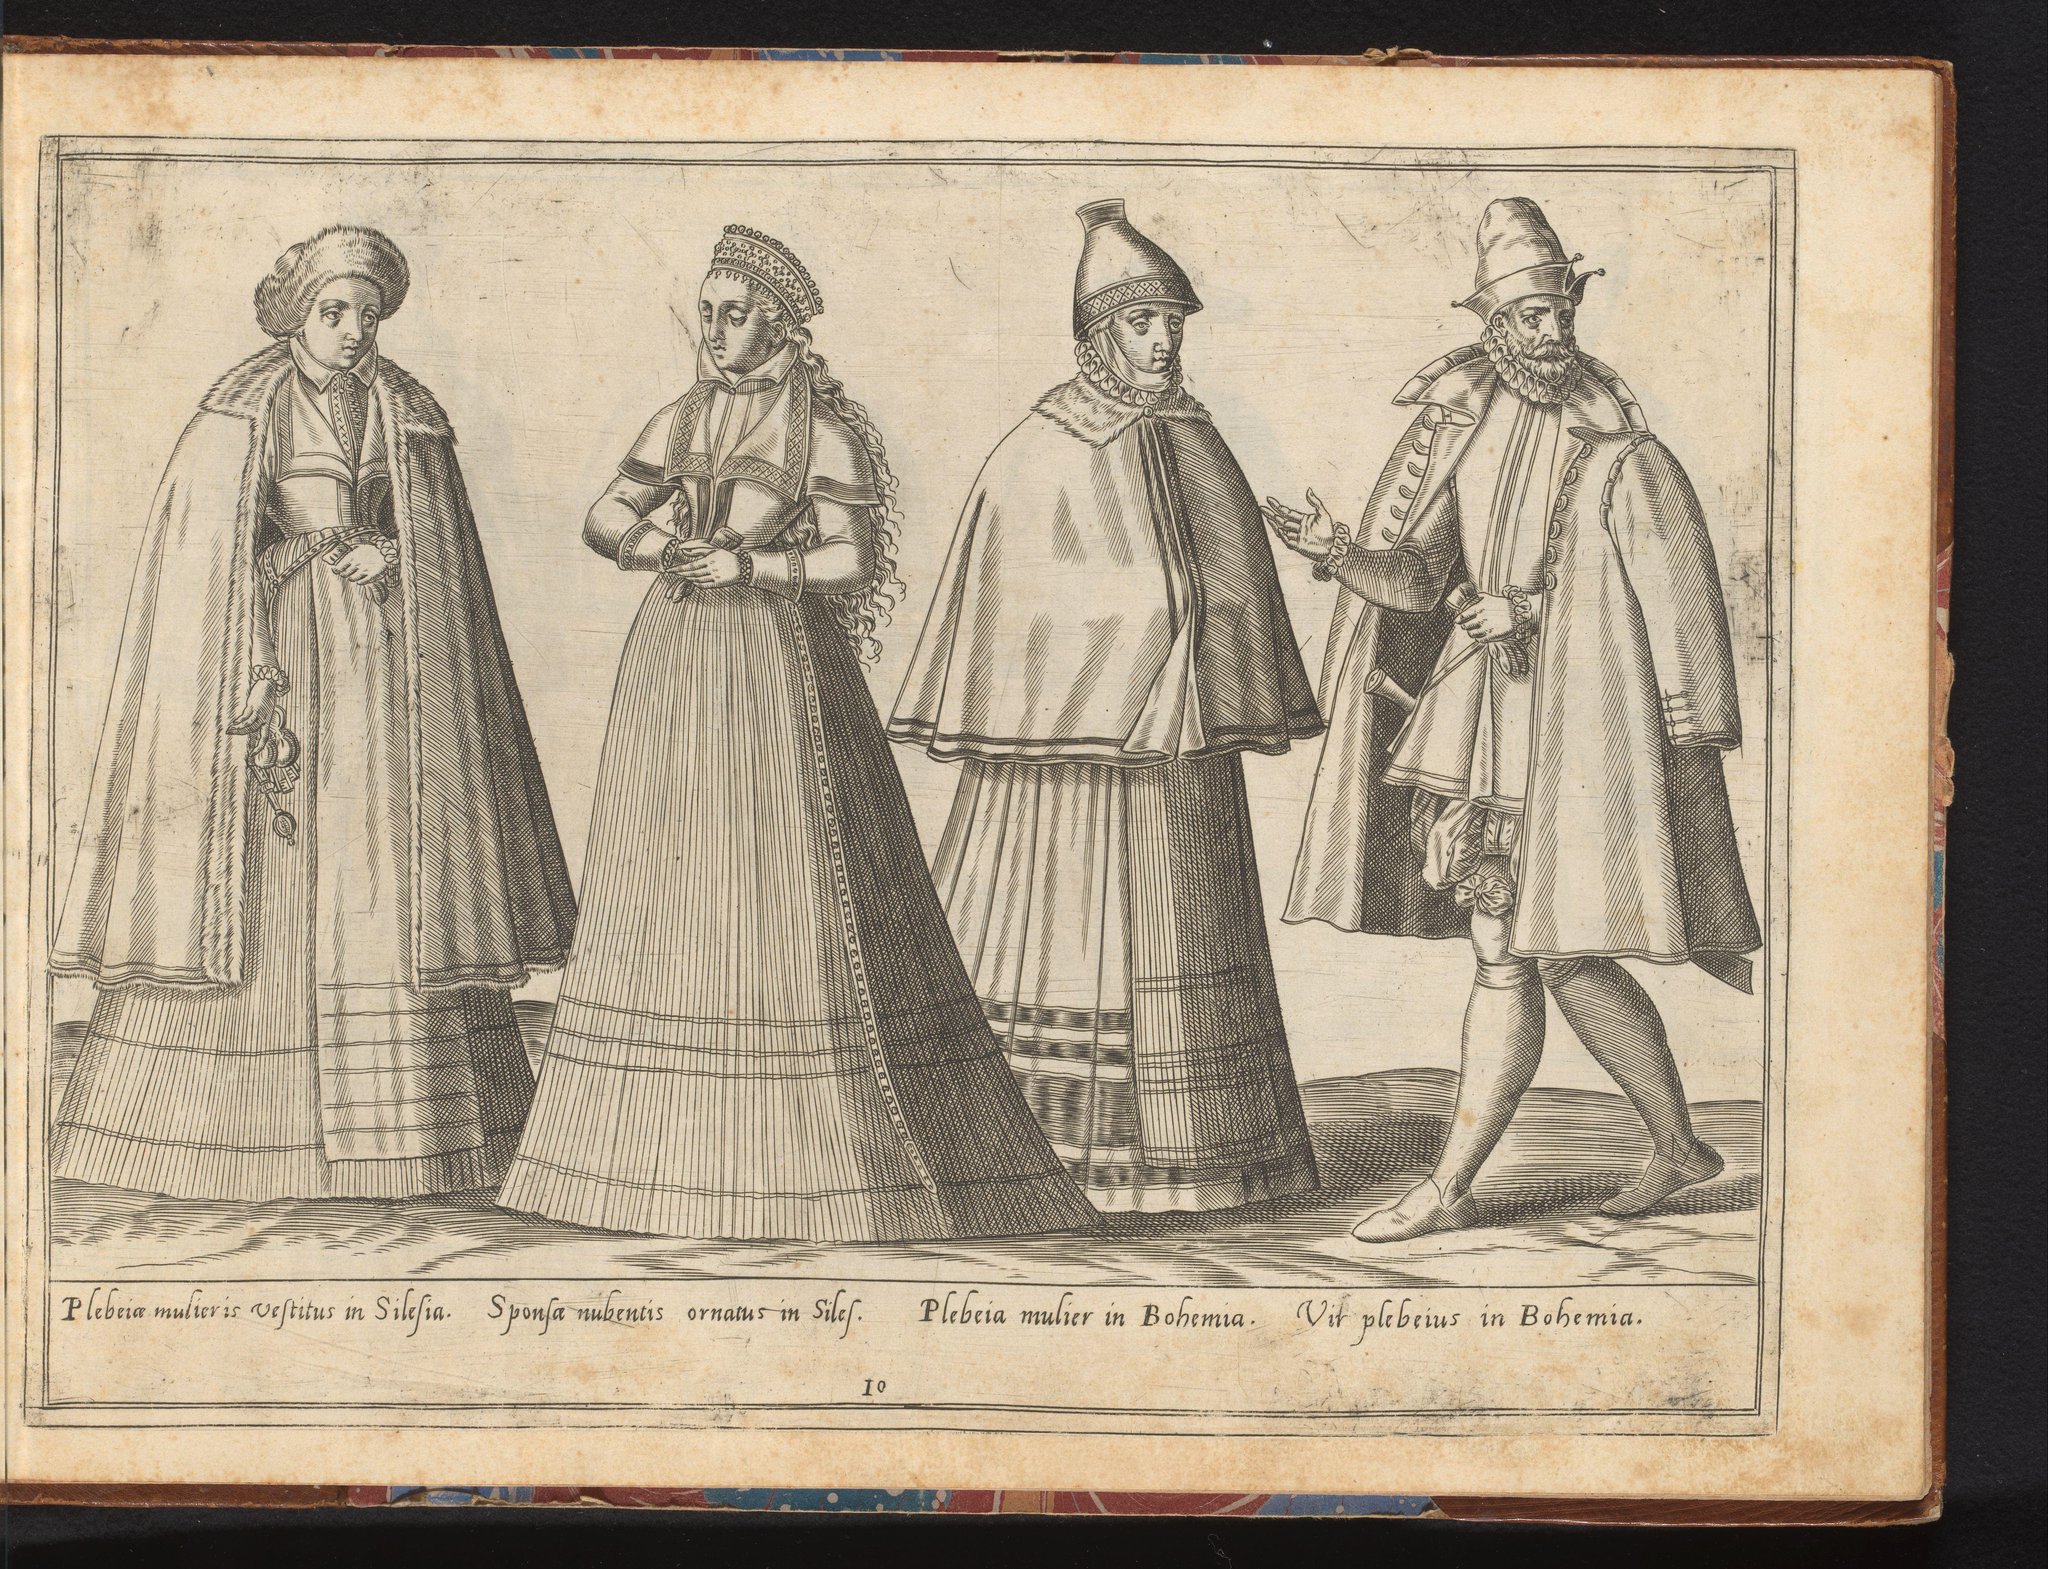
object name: album leaf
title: Drie vrouwen en een man, gekleed volgens de mode uit Silezë en Bohemen van ca. 1580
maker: abraham de bruyn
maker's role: print maker, publisher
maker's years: 1540-1587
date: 1581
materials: paper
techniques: engraving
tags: europeans: germans (+ women), europeans: germans (+ costume), clothes, costume (+ men's clothes)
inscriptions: number: ‘10’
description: Links twee vrouwen uit Silezië; rechts een man en een vrouw uit Bohemen. Prent uit het boek 'Omnium pene Europae, Asiae, Aphricae atque Americae gentium habitus...', 1581. De prent maakt deel uit van een album.